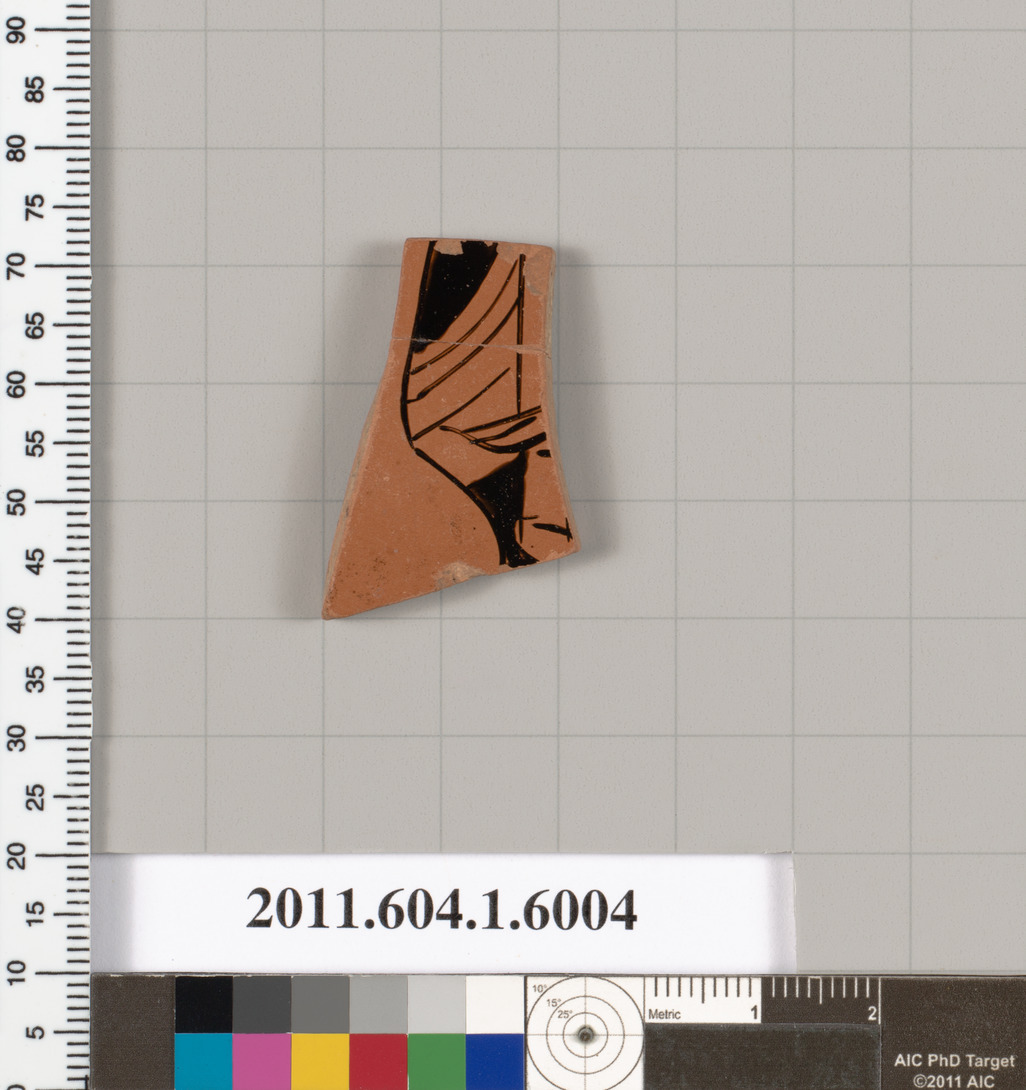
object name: kylix fragment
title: Terracotta fragment of a kylix (drinking cup)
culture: greek, attic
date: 510-500 BCE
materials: terracotta